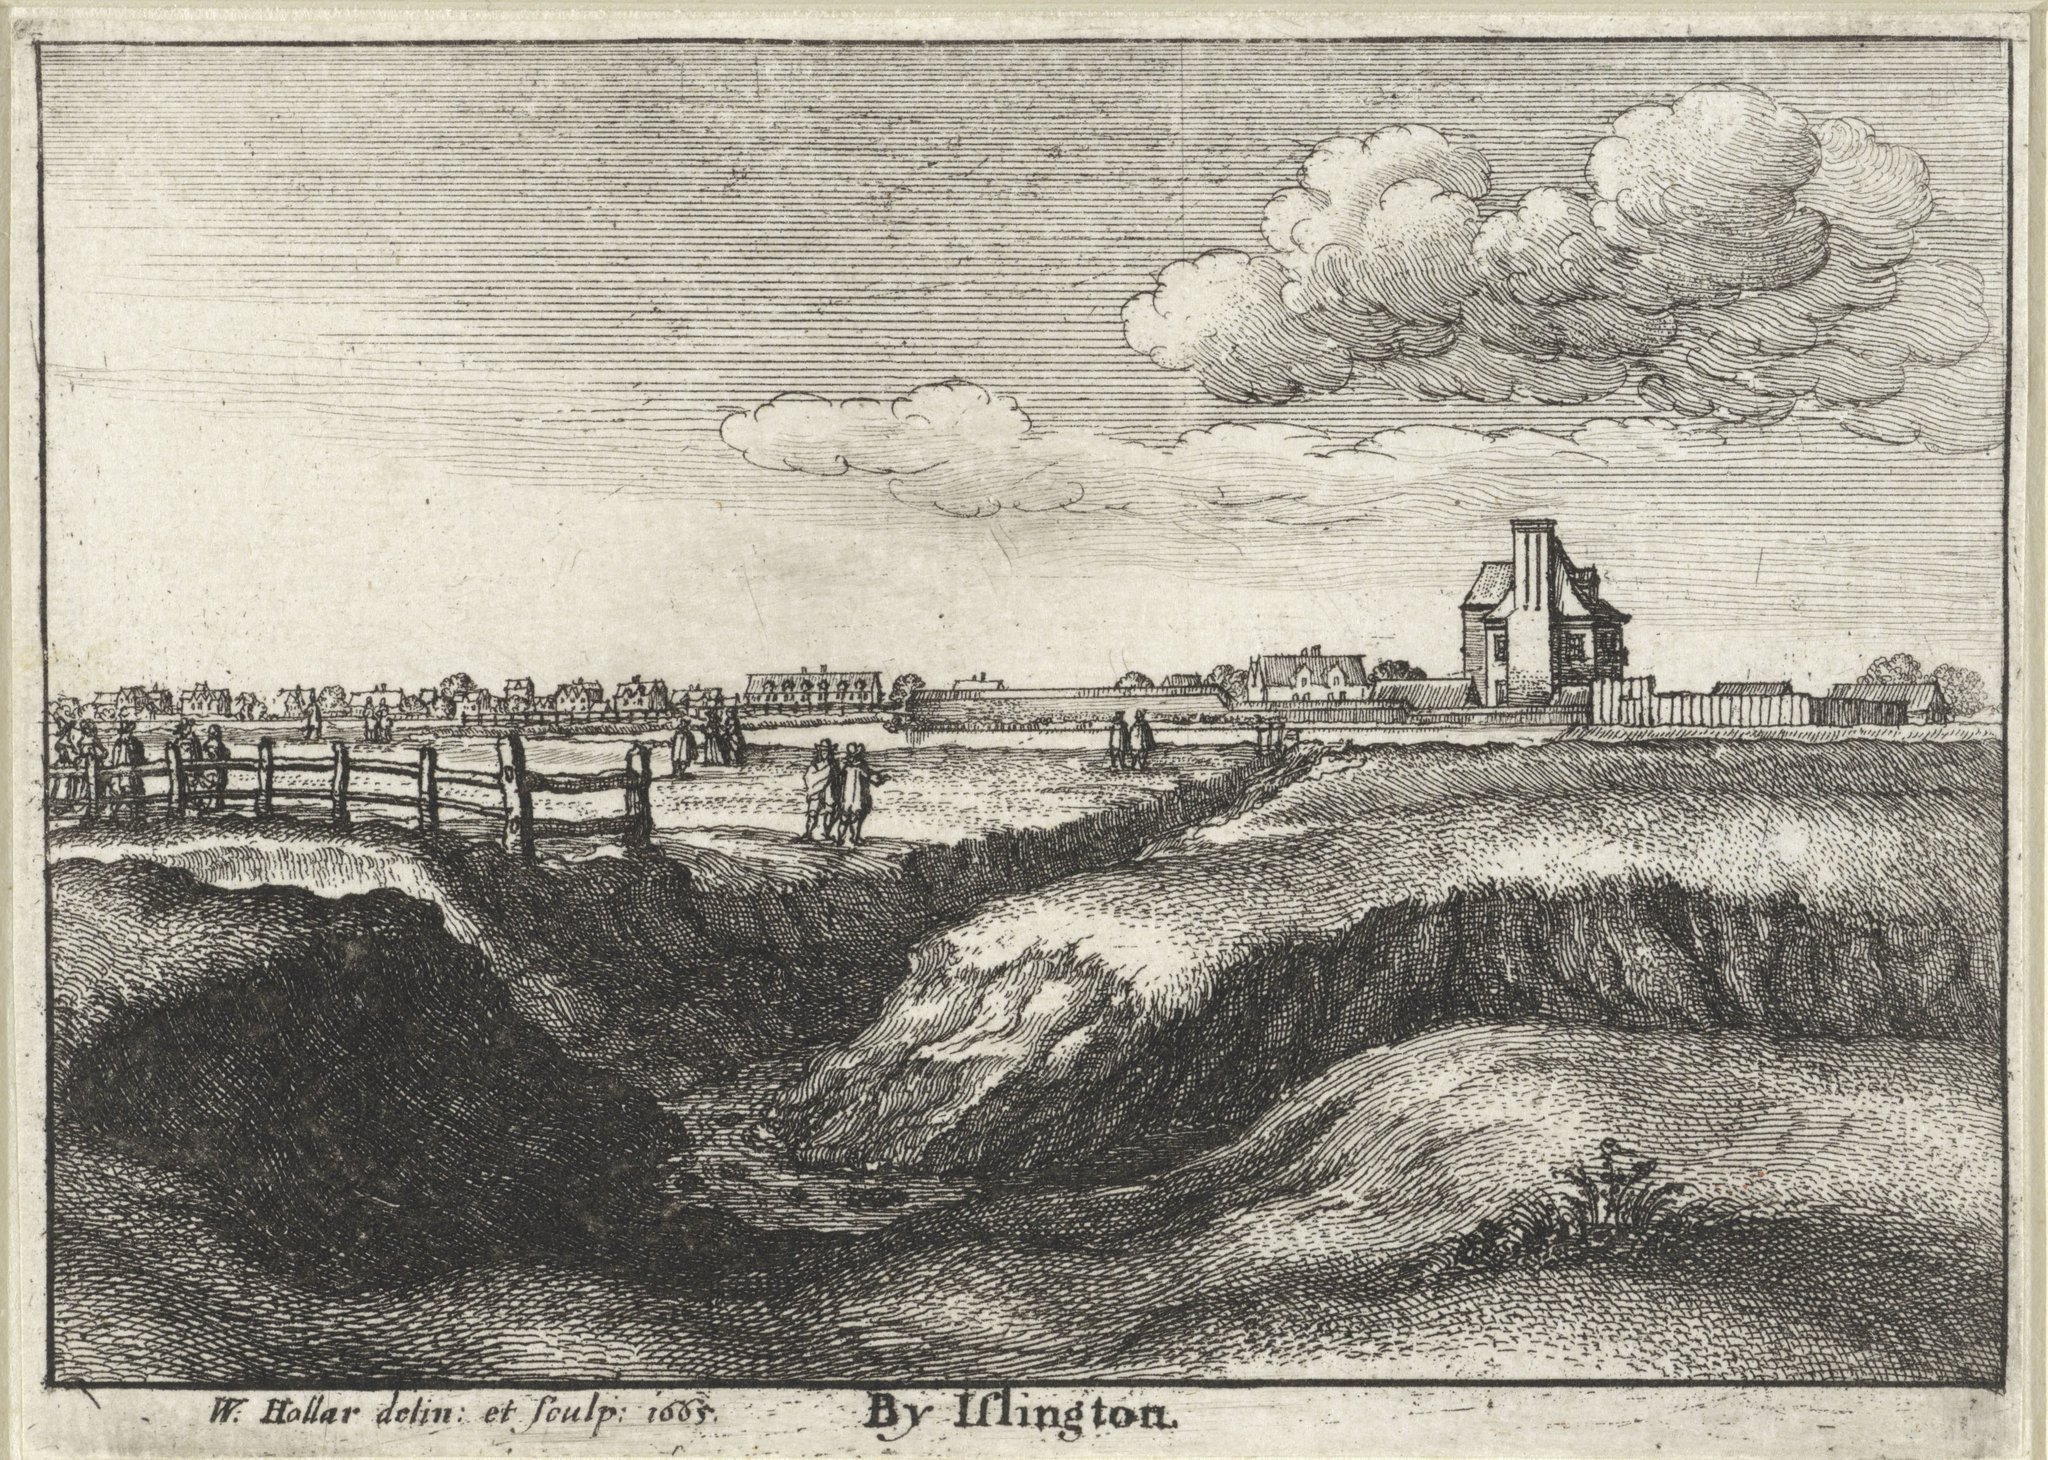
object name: print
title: Gezicht op Islington (Londen) met greppel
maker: wenceslaus hollar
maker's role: draughtsman, print maker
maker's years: 1607-1677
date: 1665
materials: paper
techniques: etching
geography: london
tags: city-view, and landscape with man-made constructions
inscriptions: collector's mark: Lugt 240, collector's mark: Lugt 240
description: De prent maakt deel uit van een zesdelige serie met gezichten nabij Londen. De prent maakt deel uit van een zesdelige serie met gezichten nabij Londen.